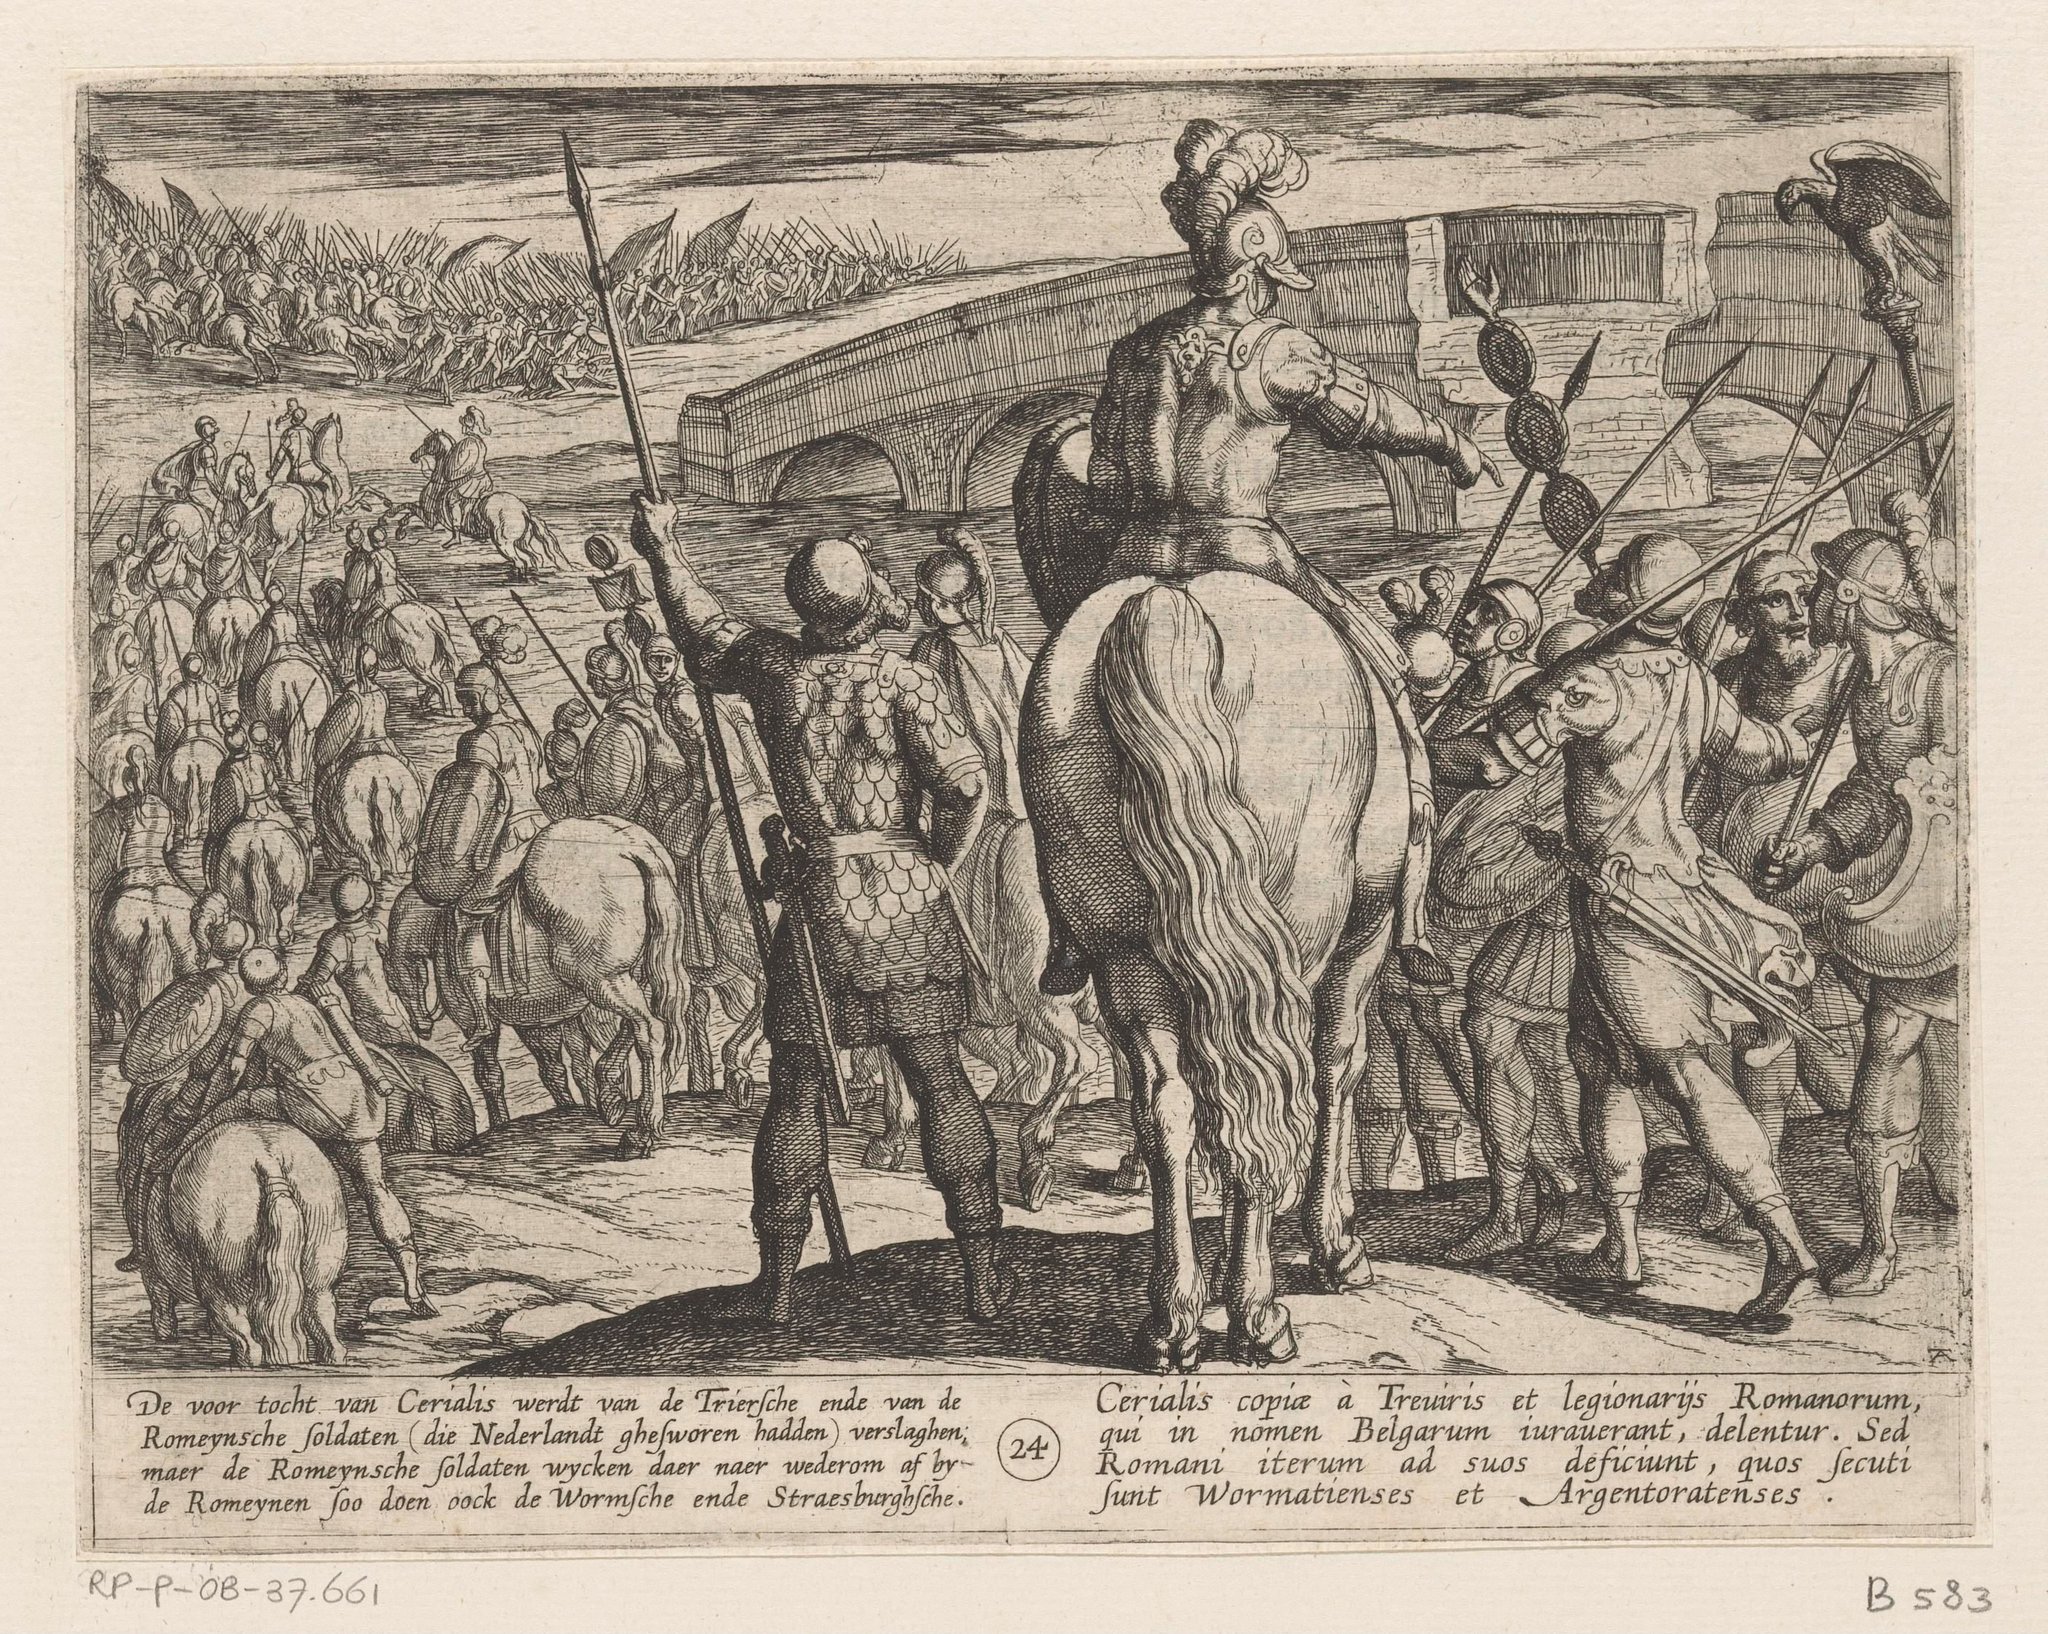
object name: print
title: Batavorum cum Romanis Bellum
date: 1611-1612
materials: paper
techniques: etching, letterpress printing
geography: antwerp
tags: warfare; military affairs (+ cavalry, horsemen), the soldier; the soldier's life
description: De voorhoede van de nieuwe Romeinse troepen draait zich om en keert terug. Onderschrift in het Nederlands en in het Latijn.